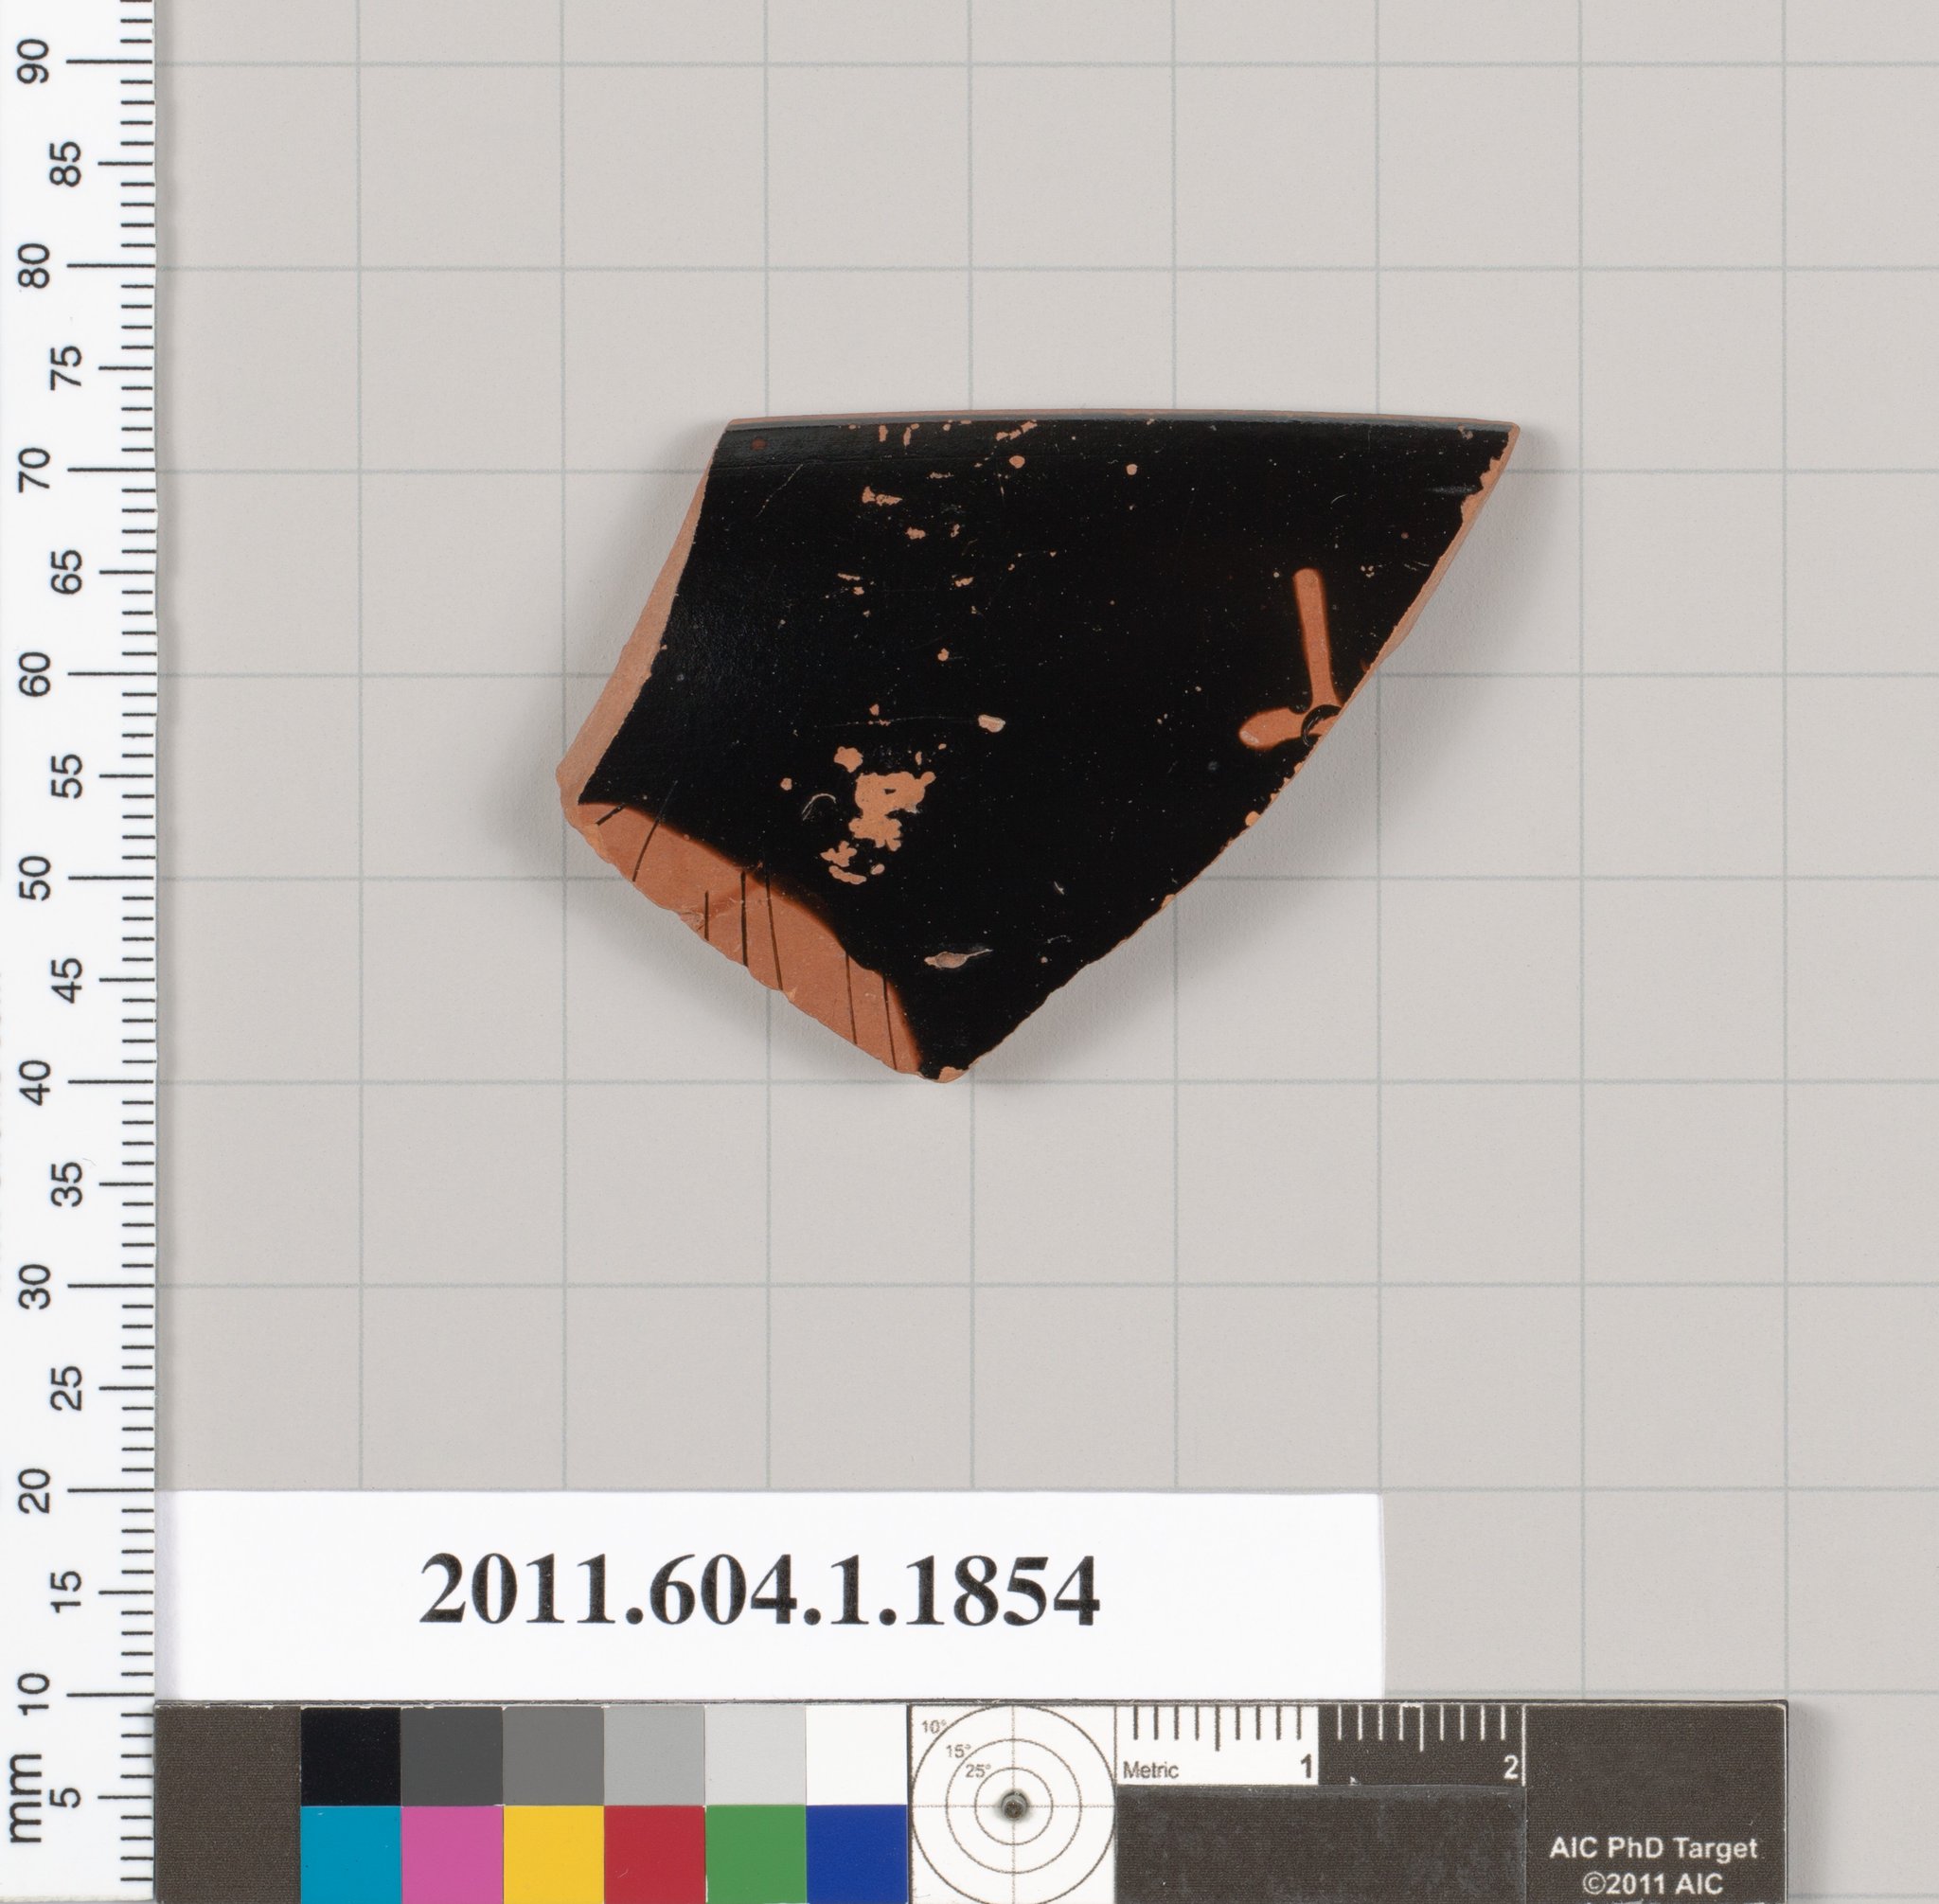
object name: kylix fragment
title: Terracotta rim fragment of a kylix (drinking cup)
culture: greek, attic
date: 475-451 BCE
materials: terracotta